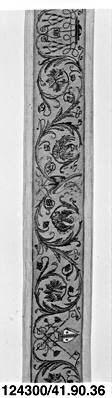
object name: border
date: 1801-1900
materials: canvas, silk